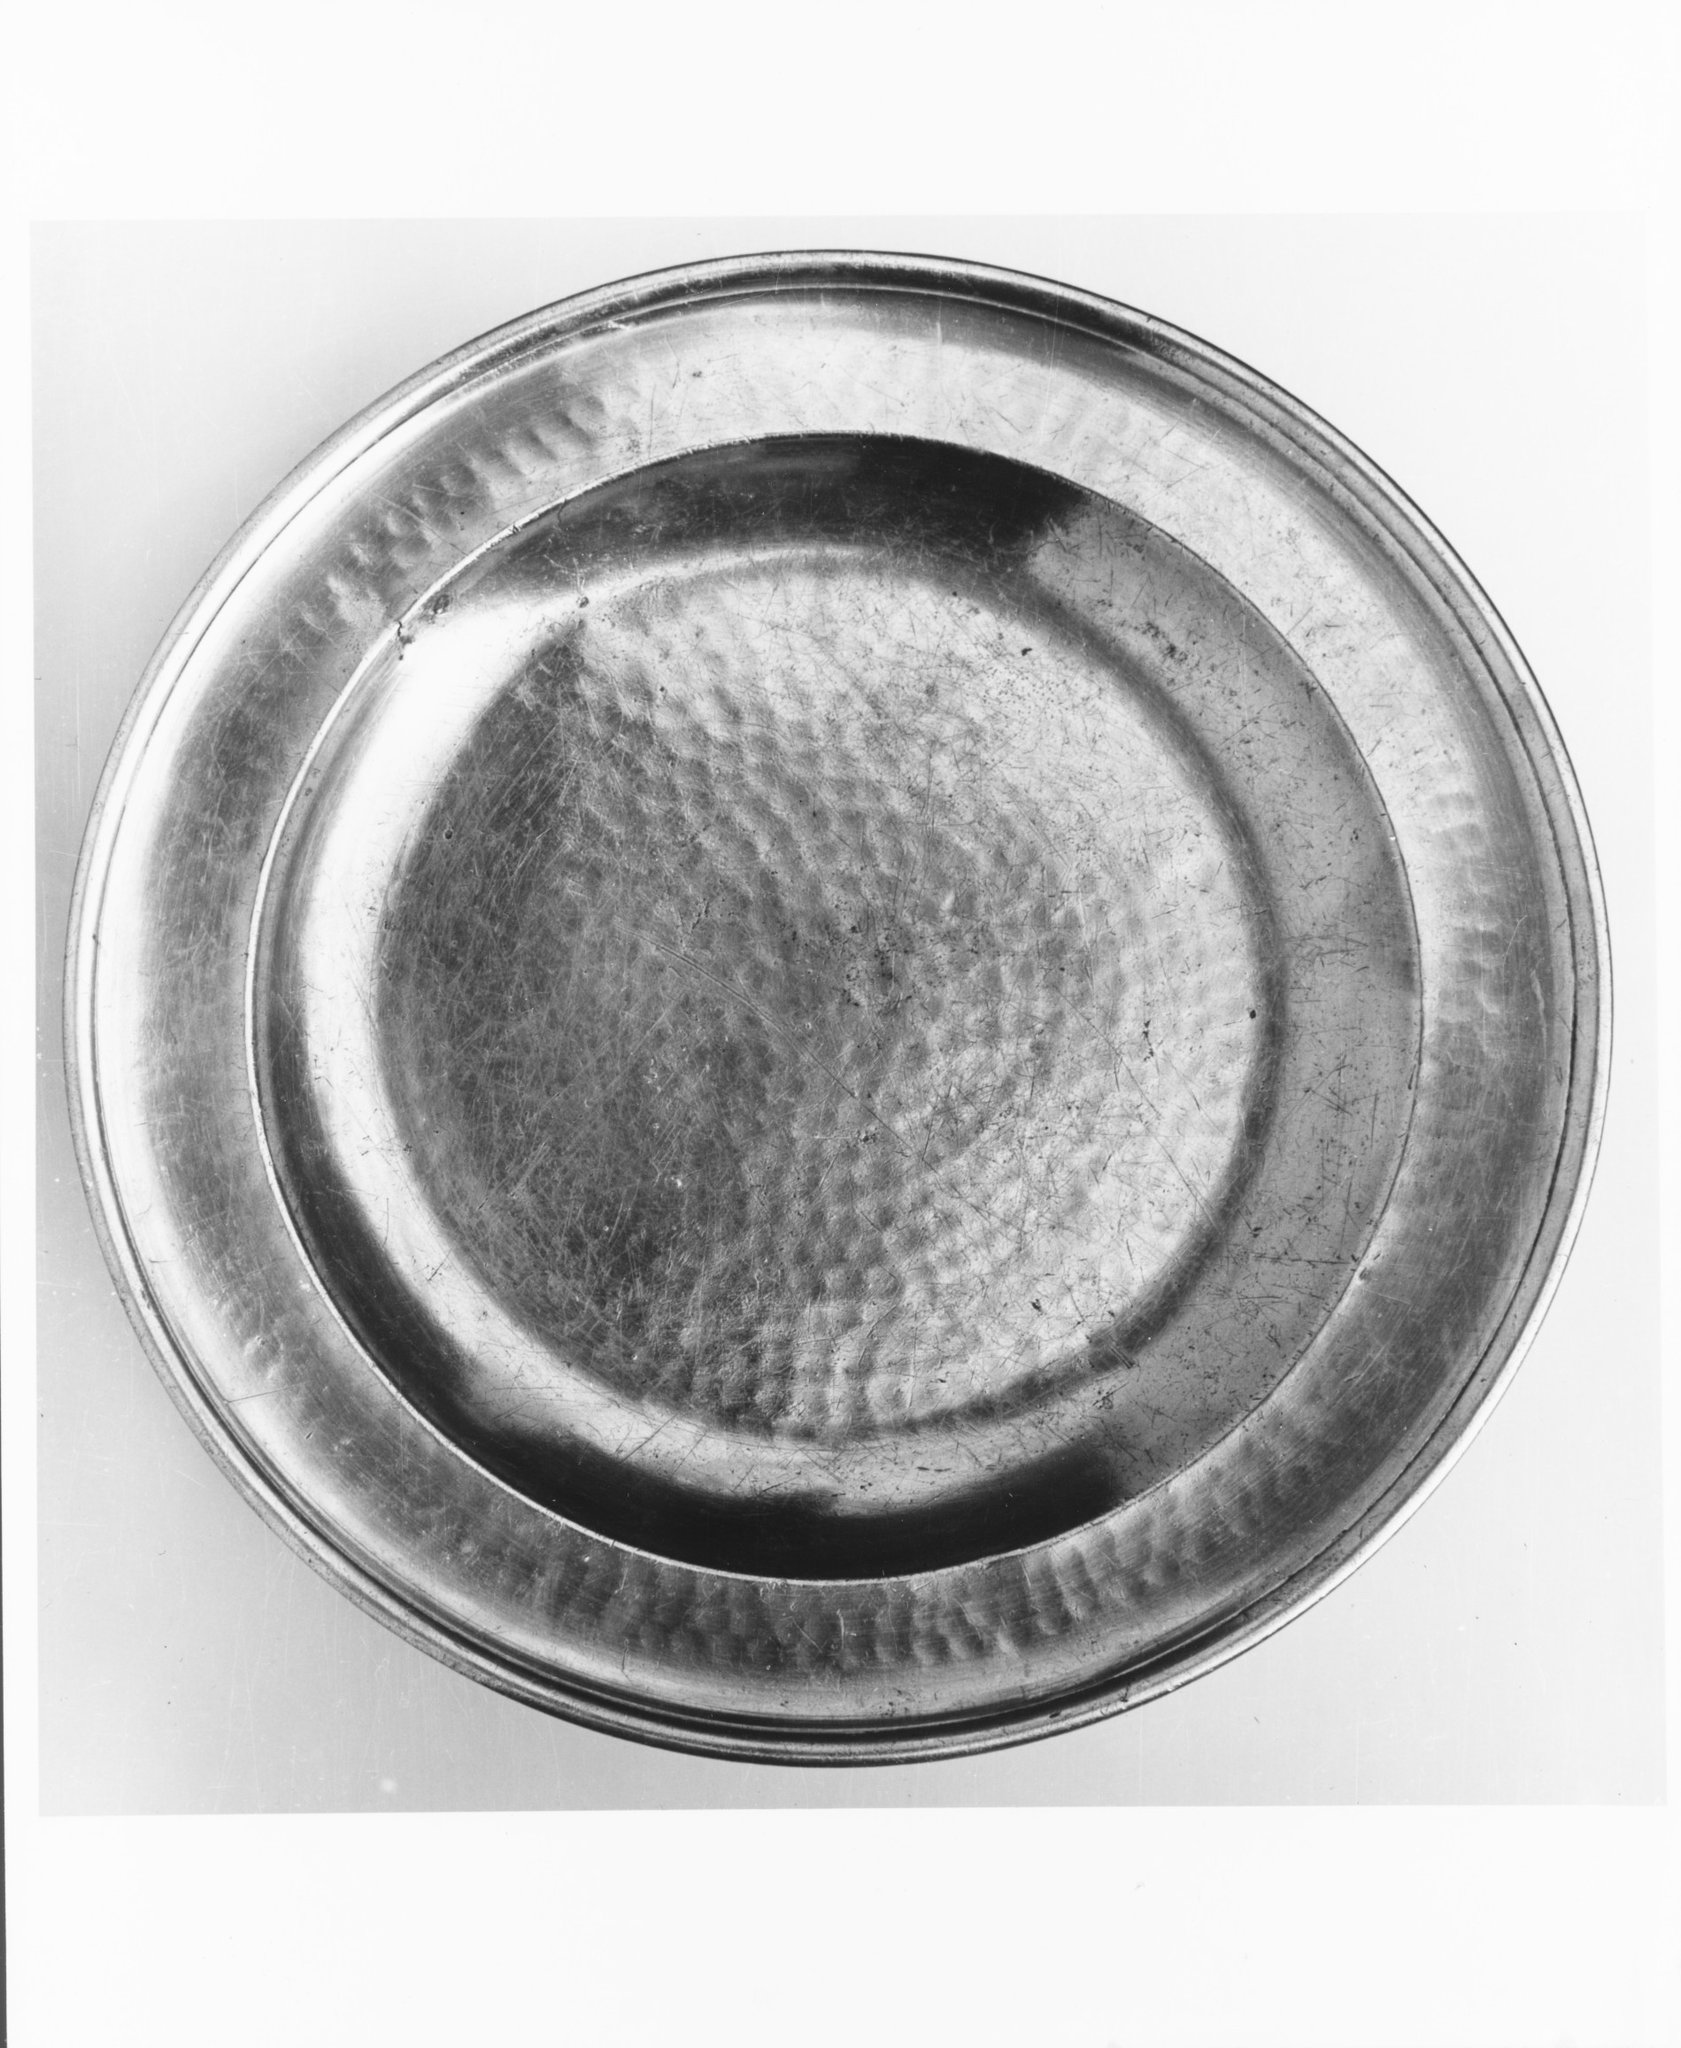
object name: dish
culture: american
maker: simon edgell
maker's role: maker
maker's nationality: american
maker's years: 1687-1742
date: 1713-1742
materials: pewter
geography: united states